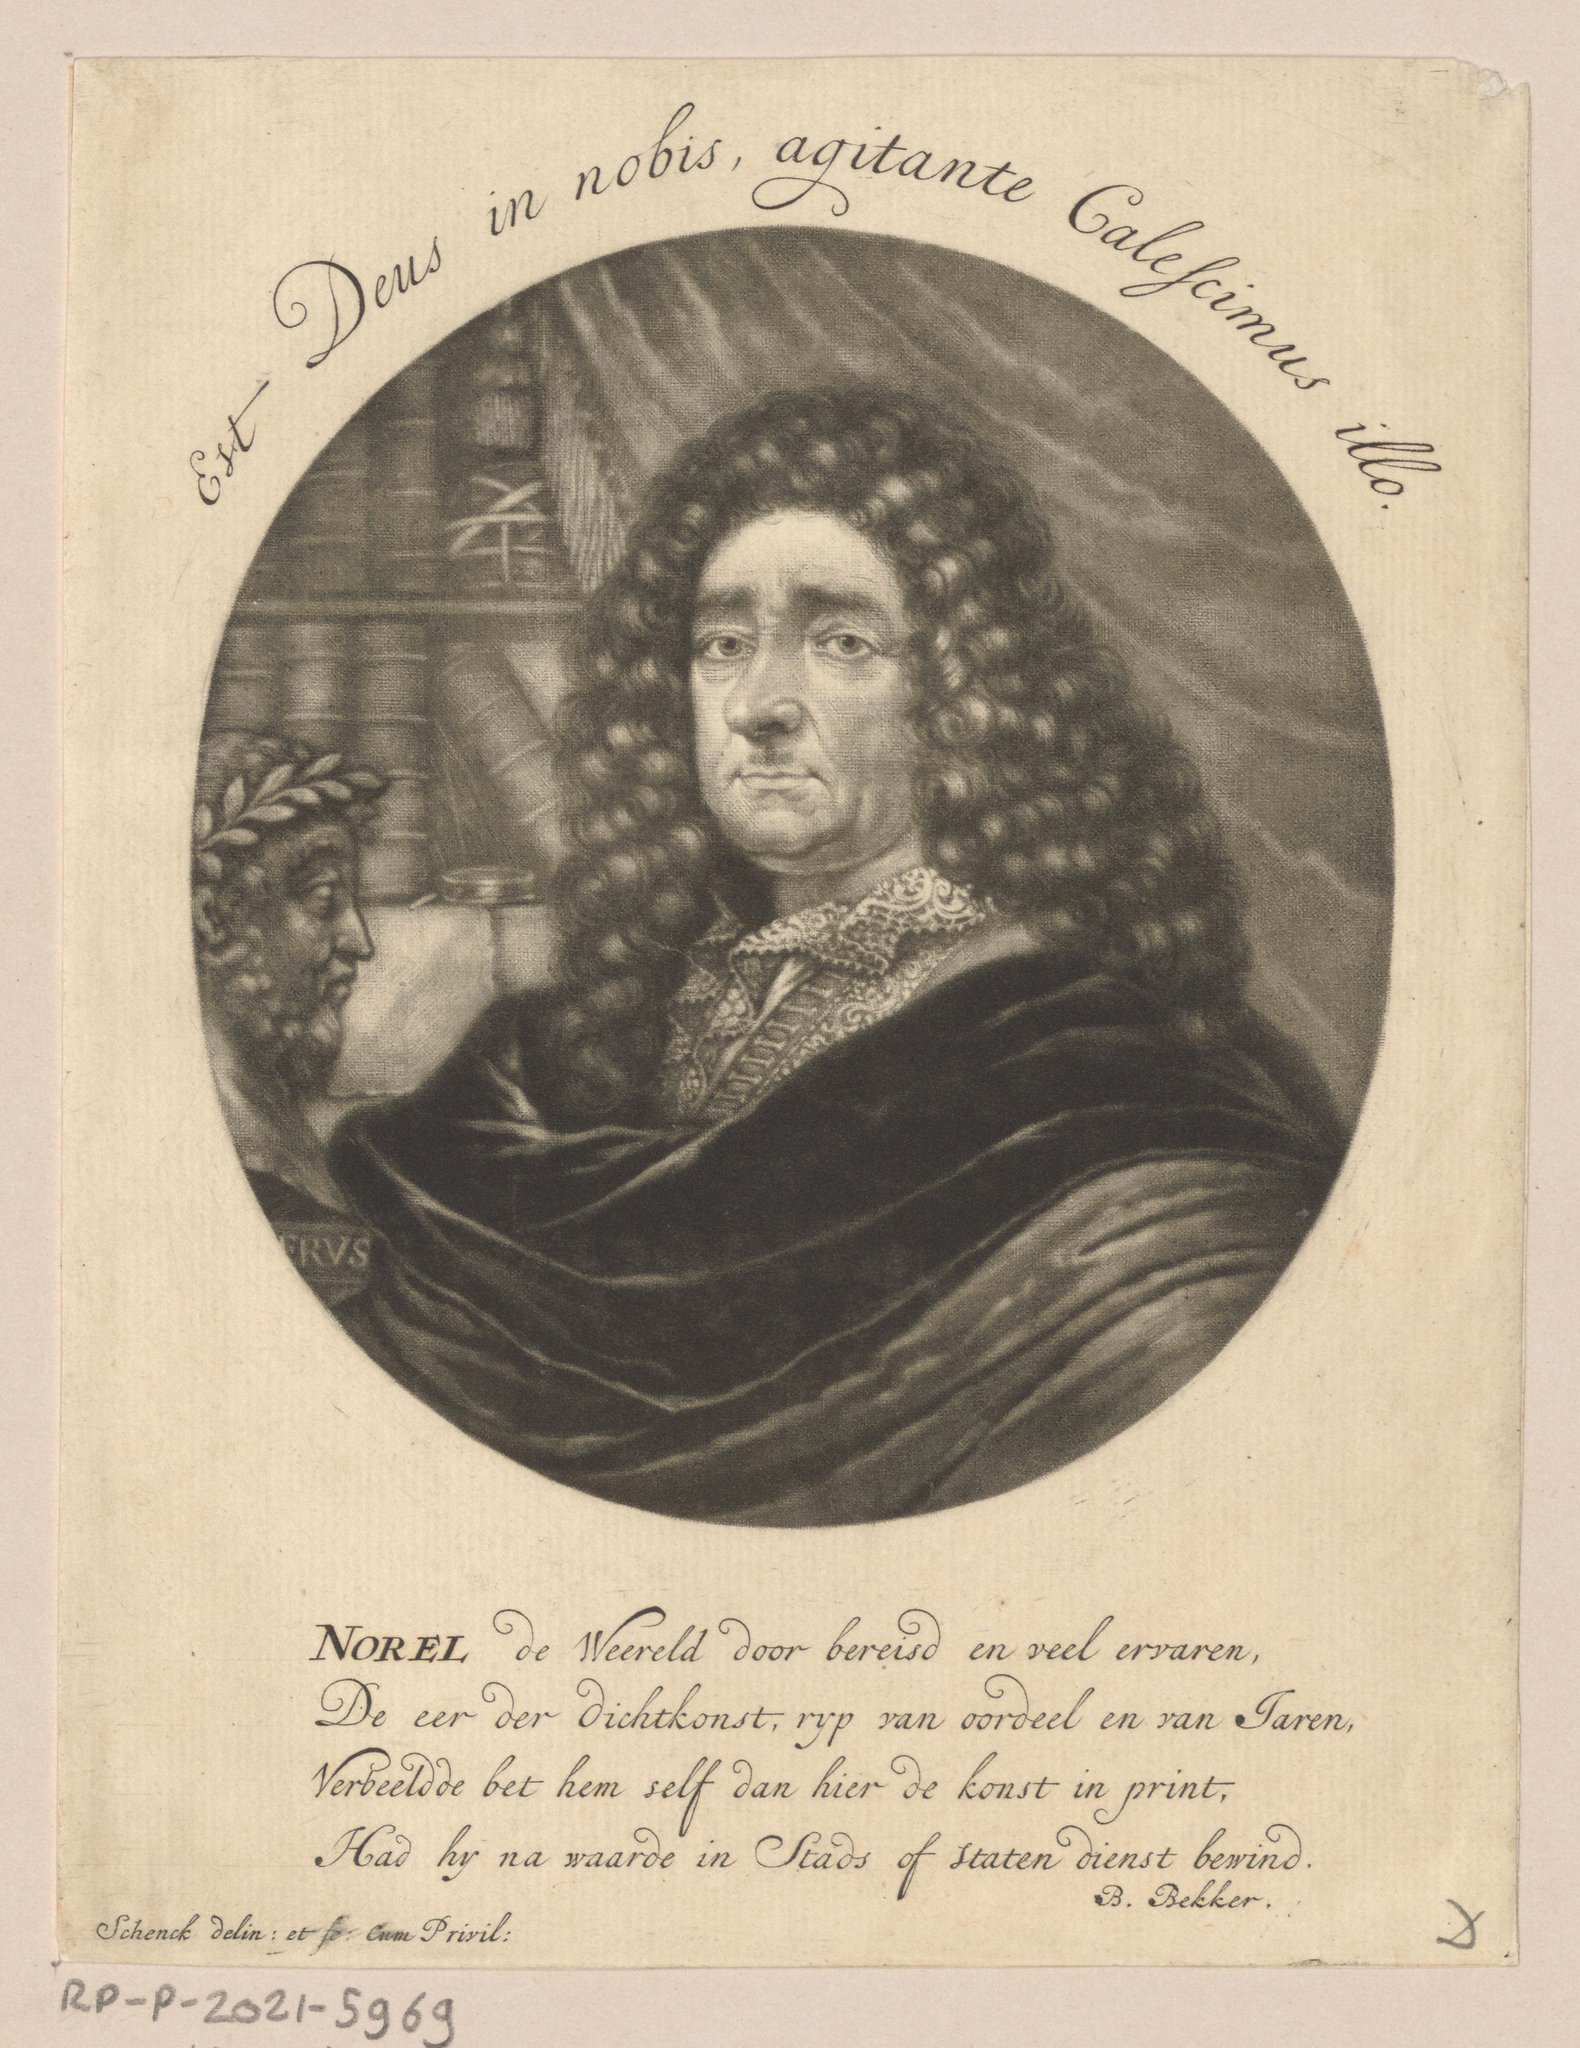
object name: print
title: Portret van Jan Norel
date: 1700-1711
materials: paper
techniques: engraving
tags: amsterdam, jan norel, historical persons, writer, poet, author